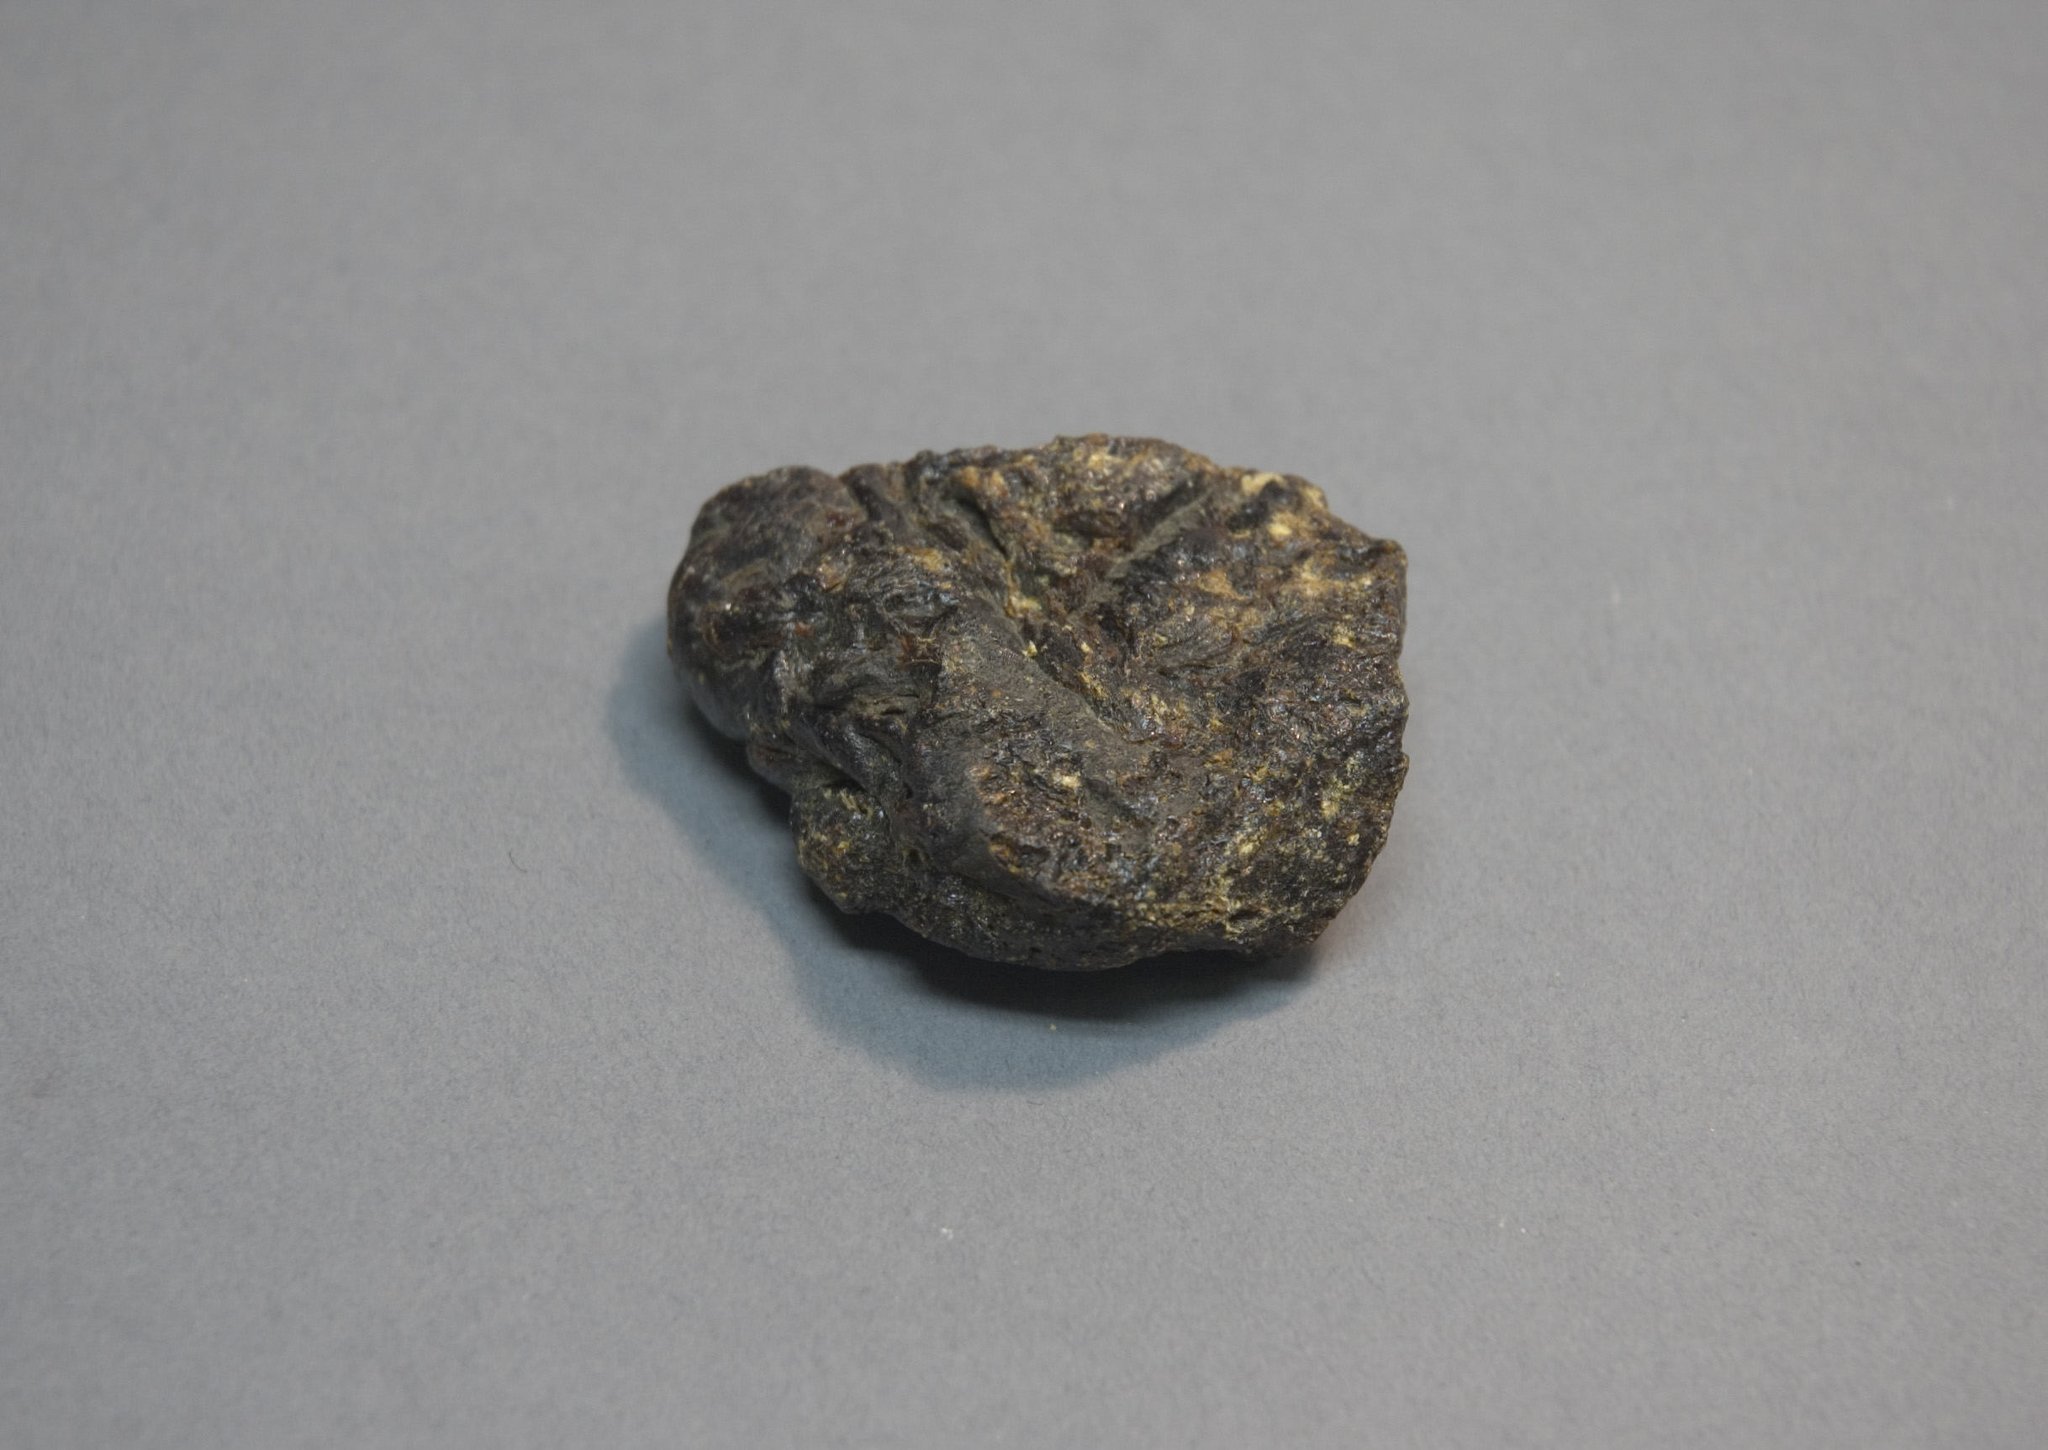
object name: jade carving material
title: Shellac Specimen for Jade Carving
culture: chinese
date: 1901-2000